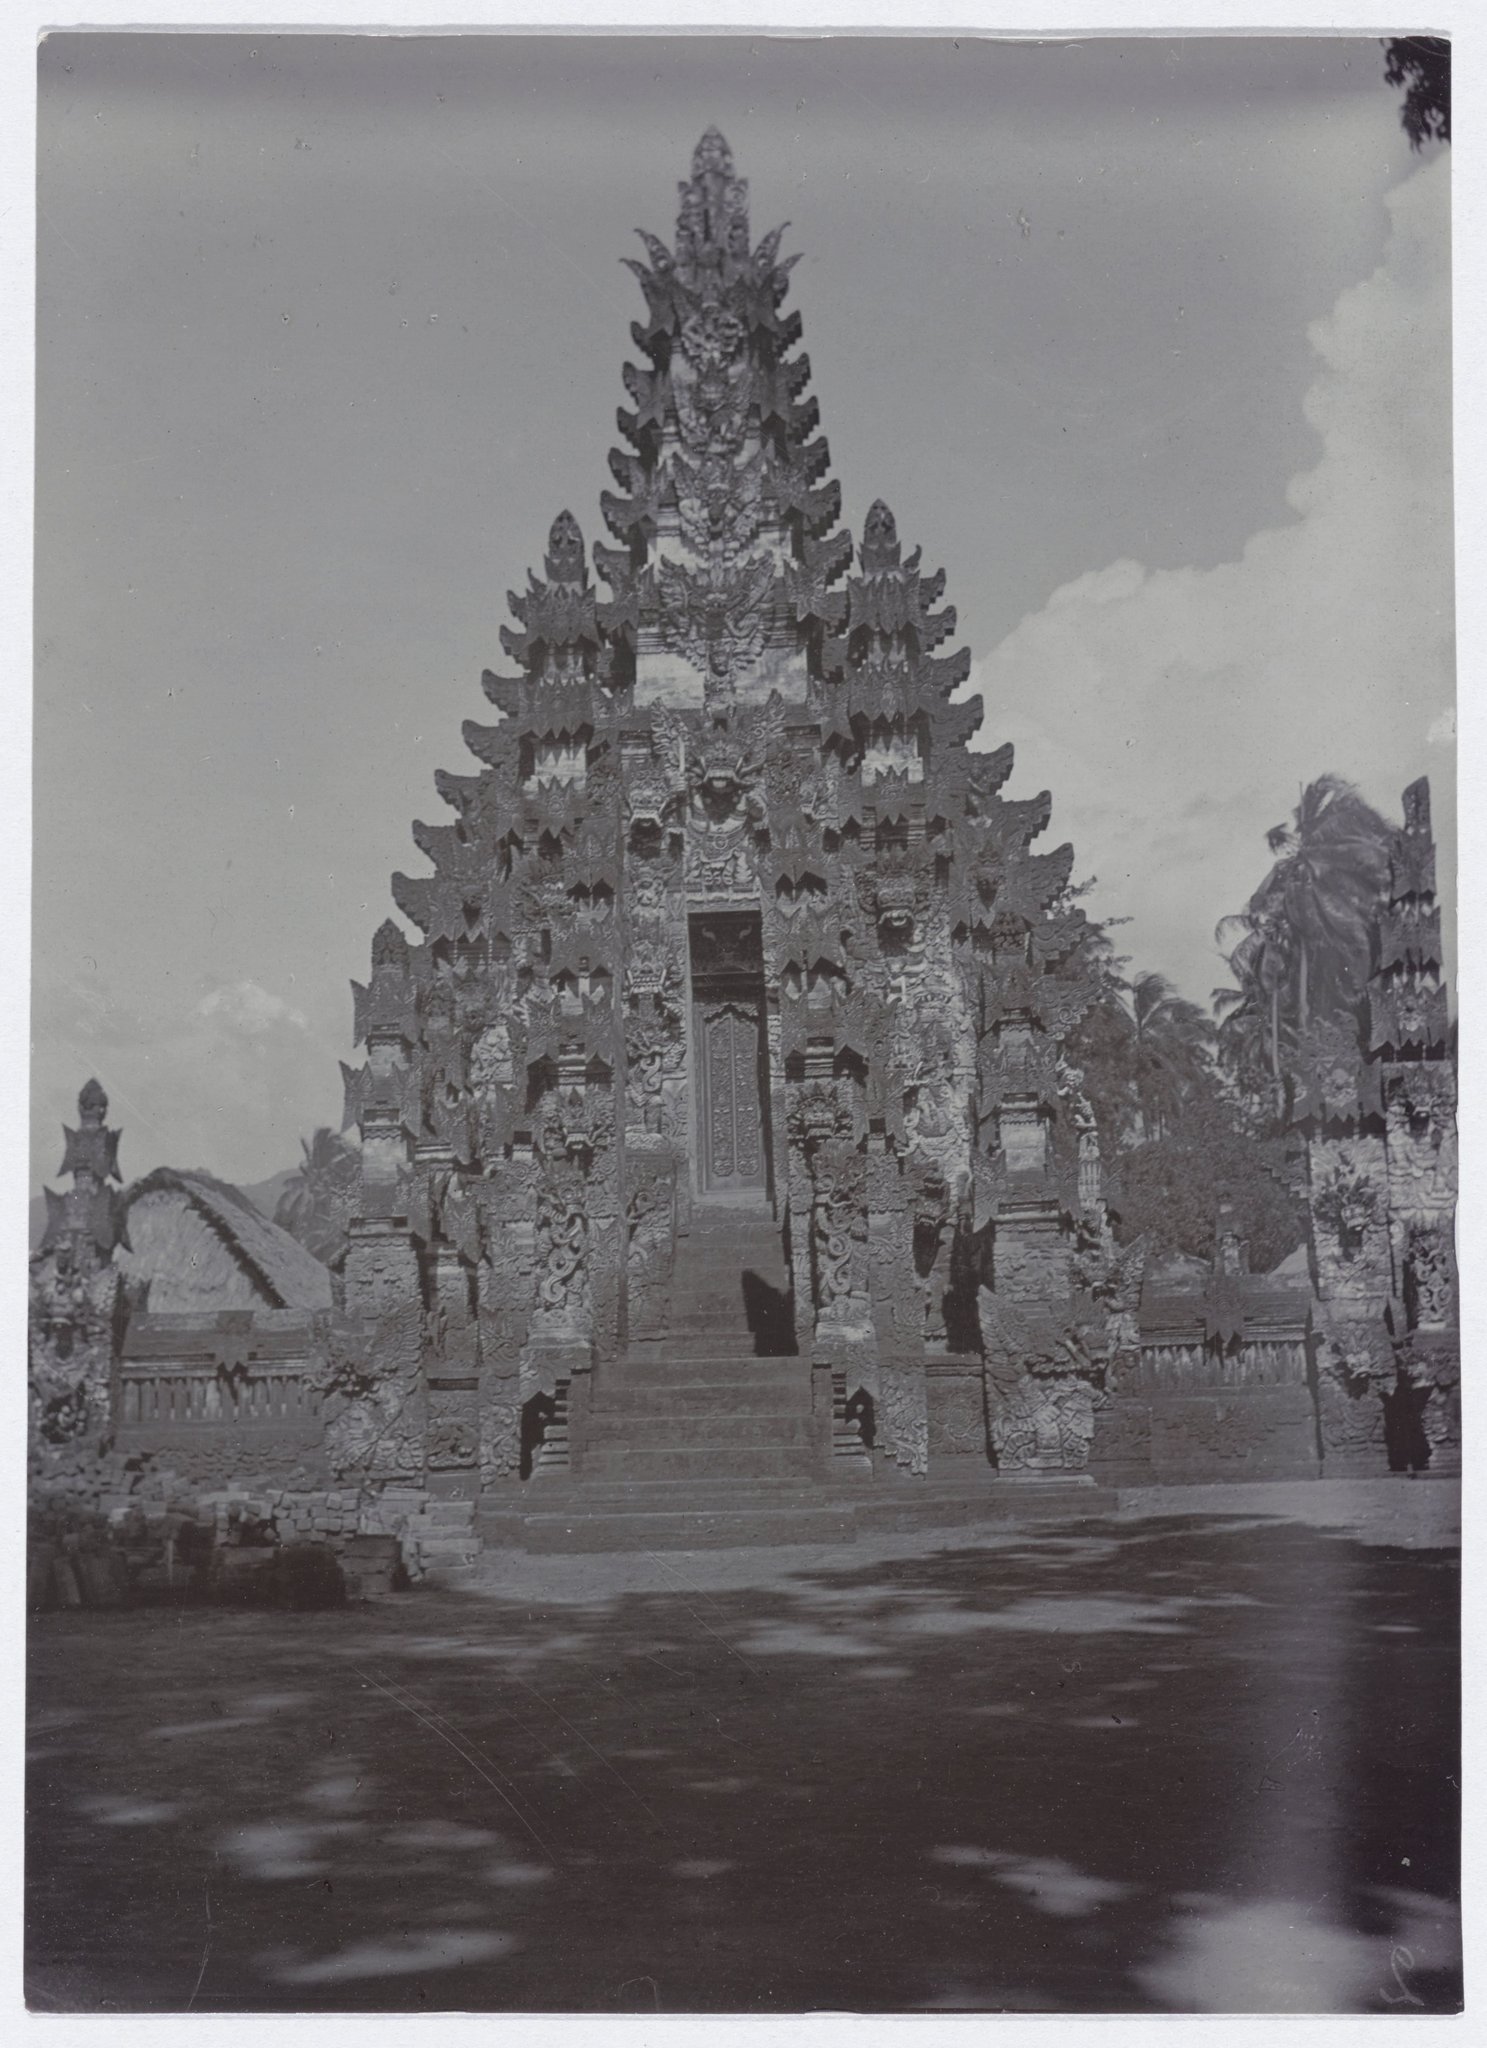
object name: photograph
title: Een tempel op noord-Bali, mogelijk bij Batur welke in 1917 door een vulkaan uitbarsting is verwoest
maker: johanna hermina marmelstein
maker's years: 1897-1990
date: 1900-1915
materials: paper, photographic support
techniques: albumen print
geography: jakarta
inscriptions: annotation: ‘17. Noord-Bali. t/ van Singaradja. Binnen-tempelpoort van Bila (zeer bekend); let op drukke ornamentiek met vele kleuren opgemerkt in tegenstelling met de voorname lijnen der zuid-Balische tempelpoorten.’